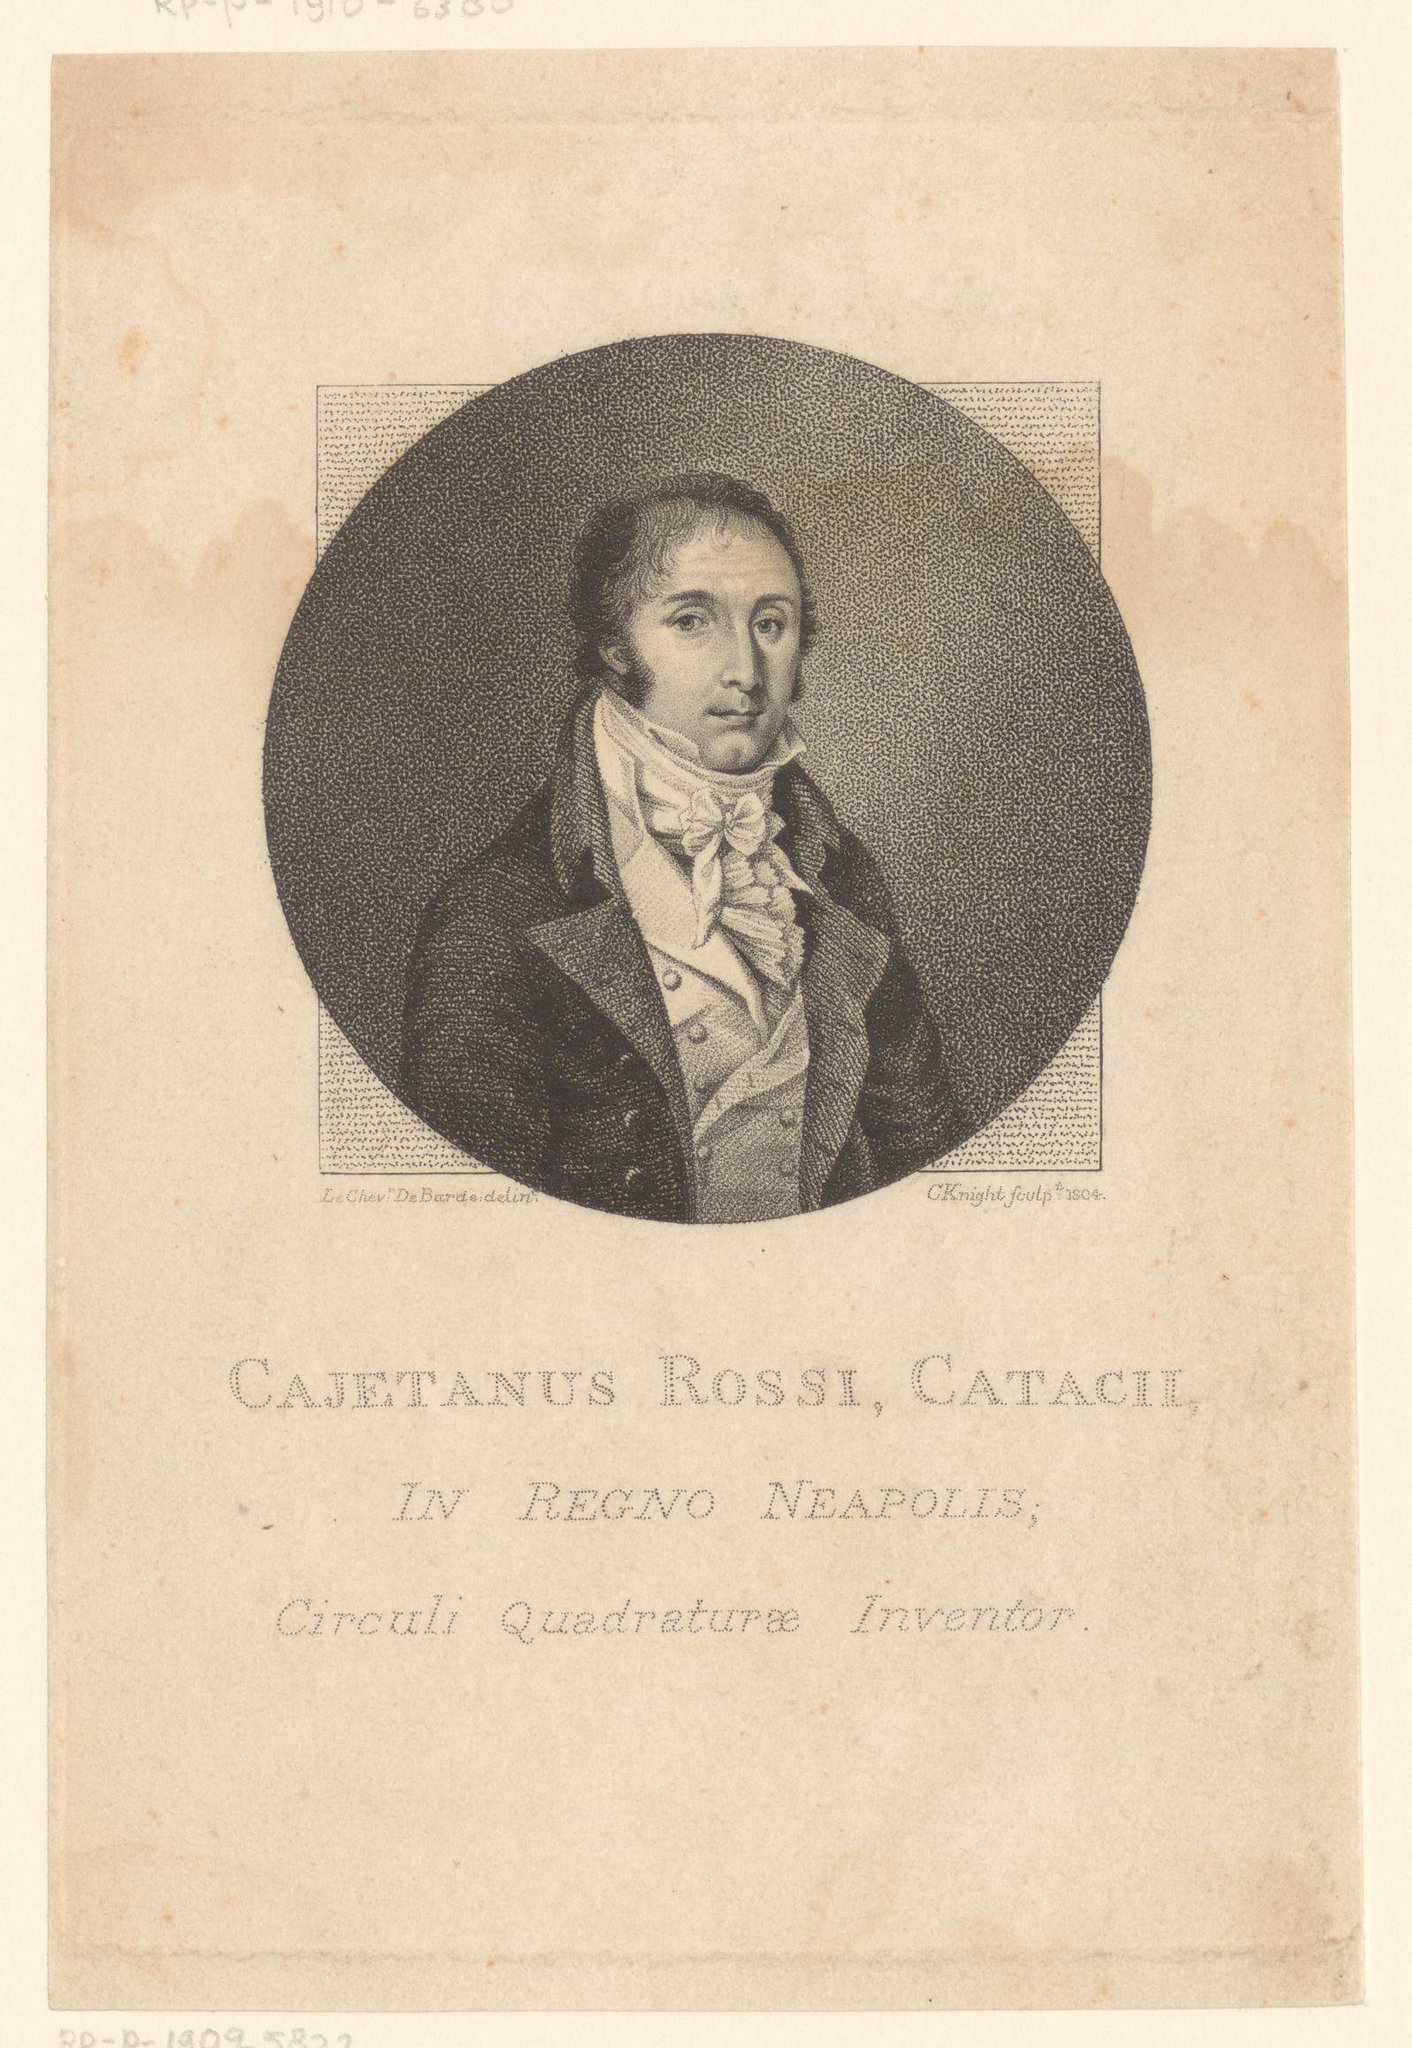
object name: print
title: Portret van Gaetano Rossi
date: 1753-1818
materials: paper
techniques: stippling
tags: historical persons, portrait of composer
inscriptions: collector's mark: Lugt 2228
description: Prent gebruikt in: Rossi. Gaetano. Soluzione esatta: e sintetica del celebratissimo problema della trisezion dell' angolo. Napels: Dalla Tipografia Chianese, 1818.